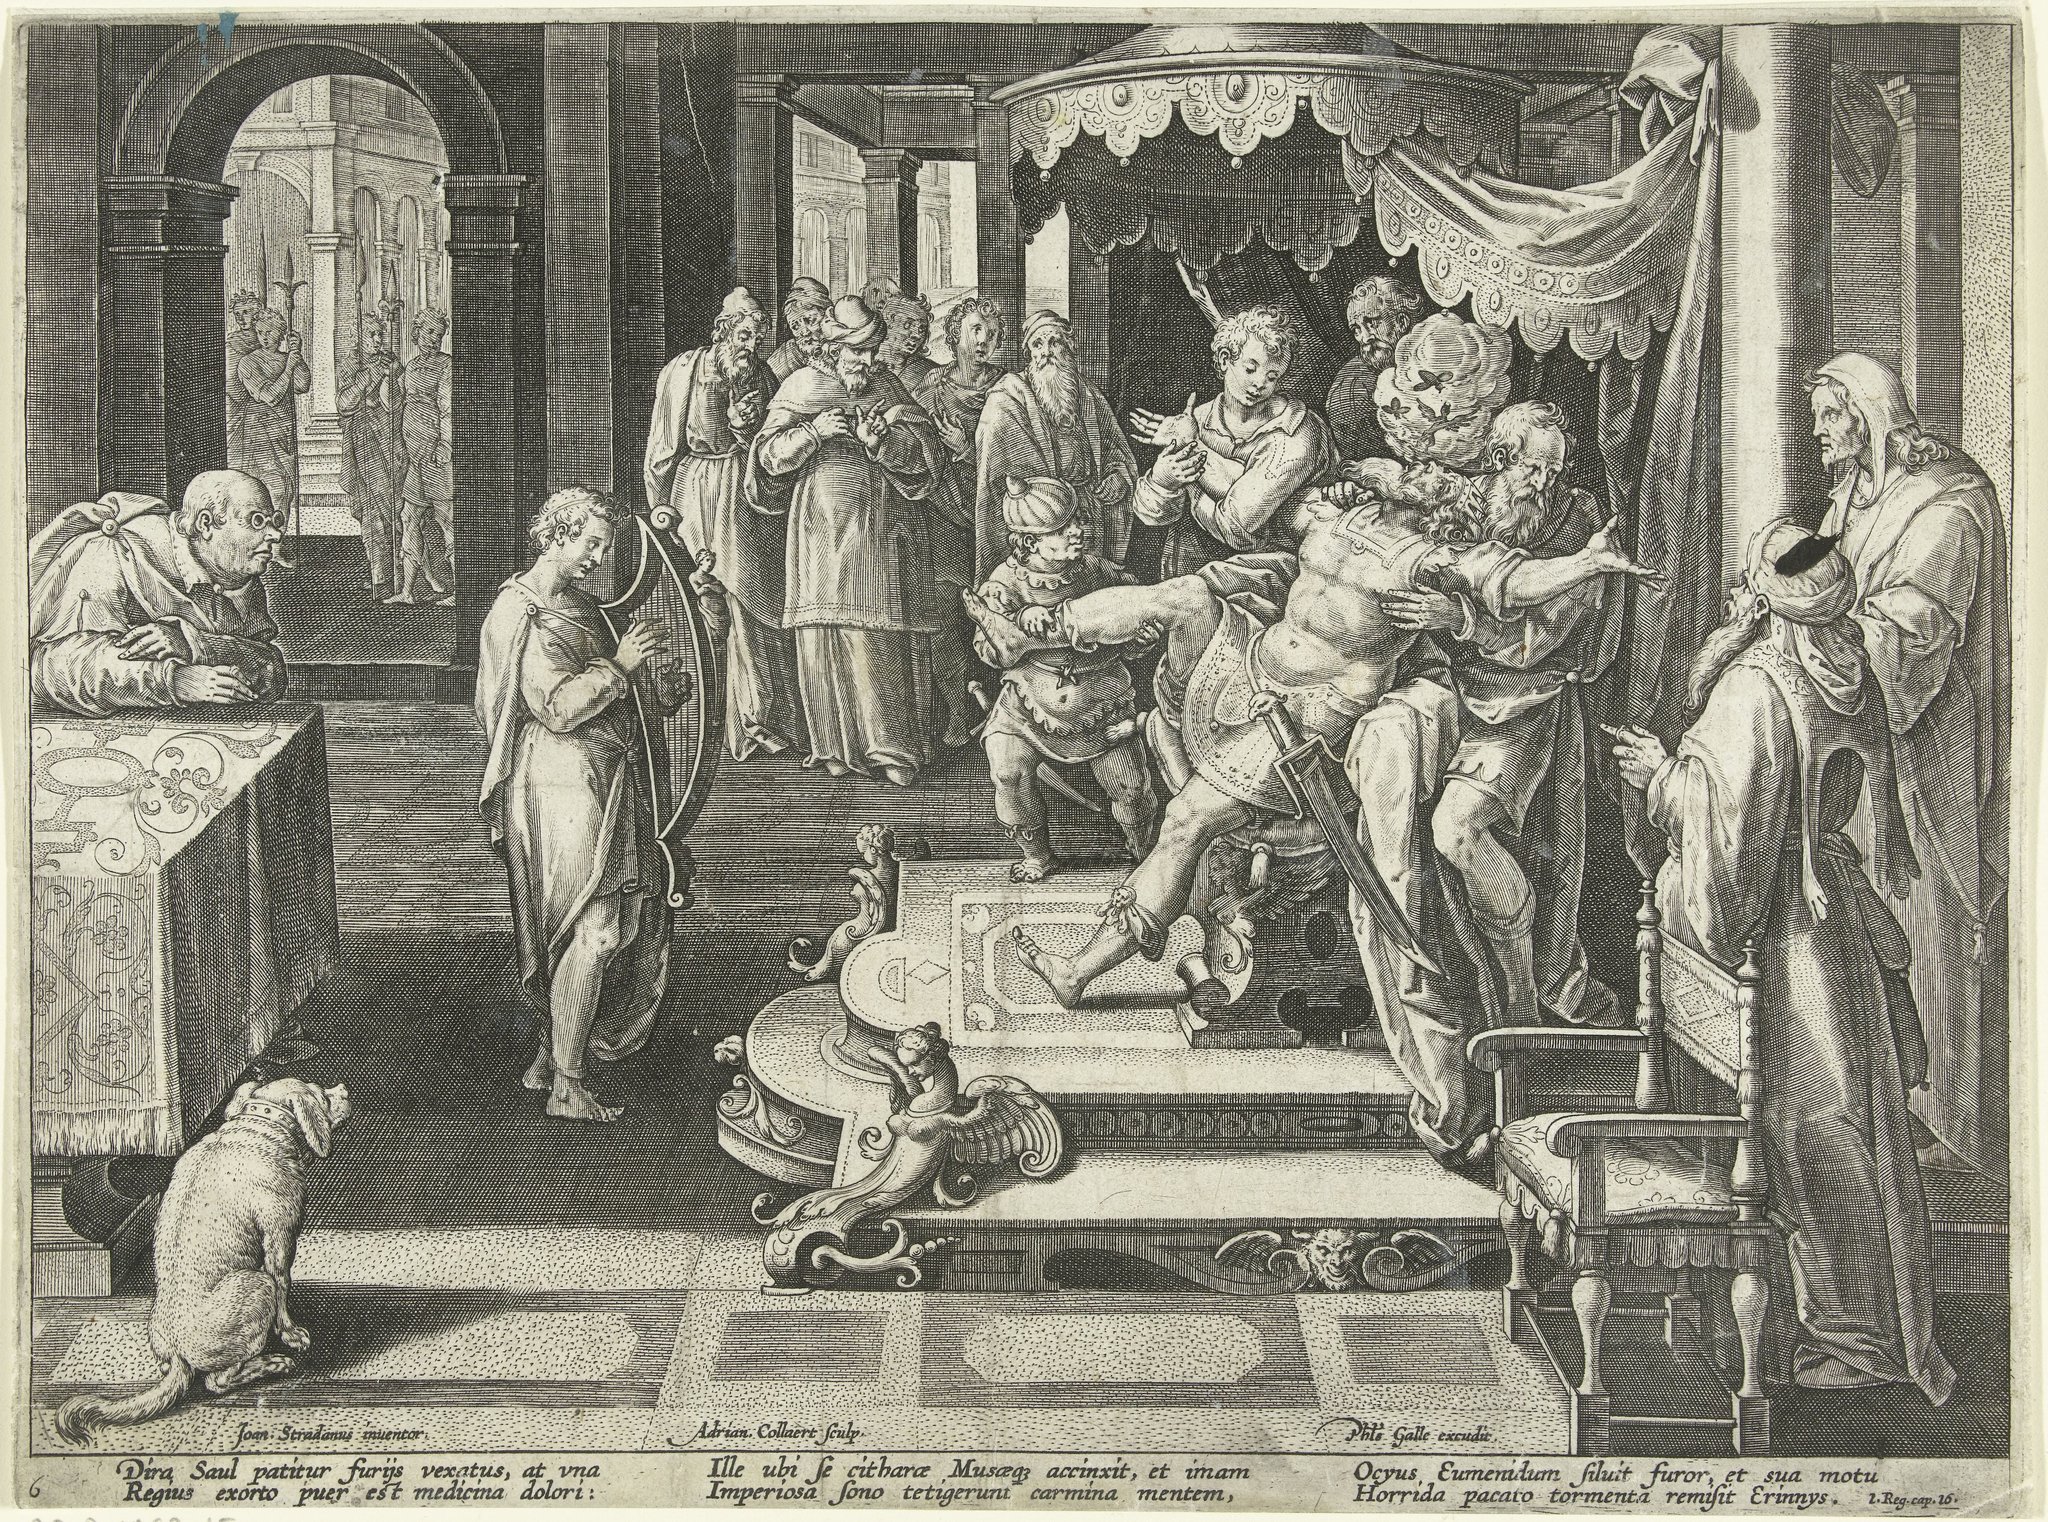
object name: print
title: David speelt op zijn harp voor Koning Saul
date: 1587-1591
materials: paper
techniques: engraving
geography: antwerp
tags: david playing his harp before saul, madness, saul troubled by an evil spirit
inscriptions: collector's mark: Lugt 2760, collector's mark: Lugt 2228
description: David speelt voor de troon van koning Saul. Het harpspel verjaagt de kwade geest die Saul kwelt. (1 Samuël 16:23) De prent heeft een Latijns onderschrift met verzen. De prent is deel van een serie met scènes uit het Oude Testament die te maken hebben met muziek.